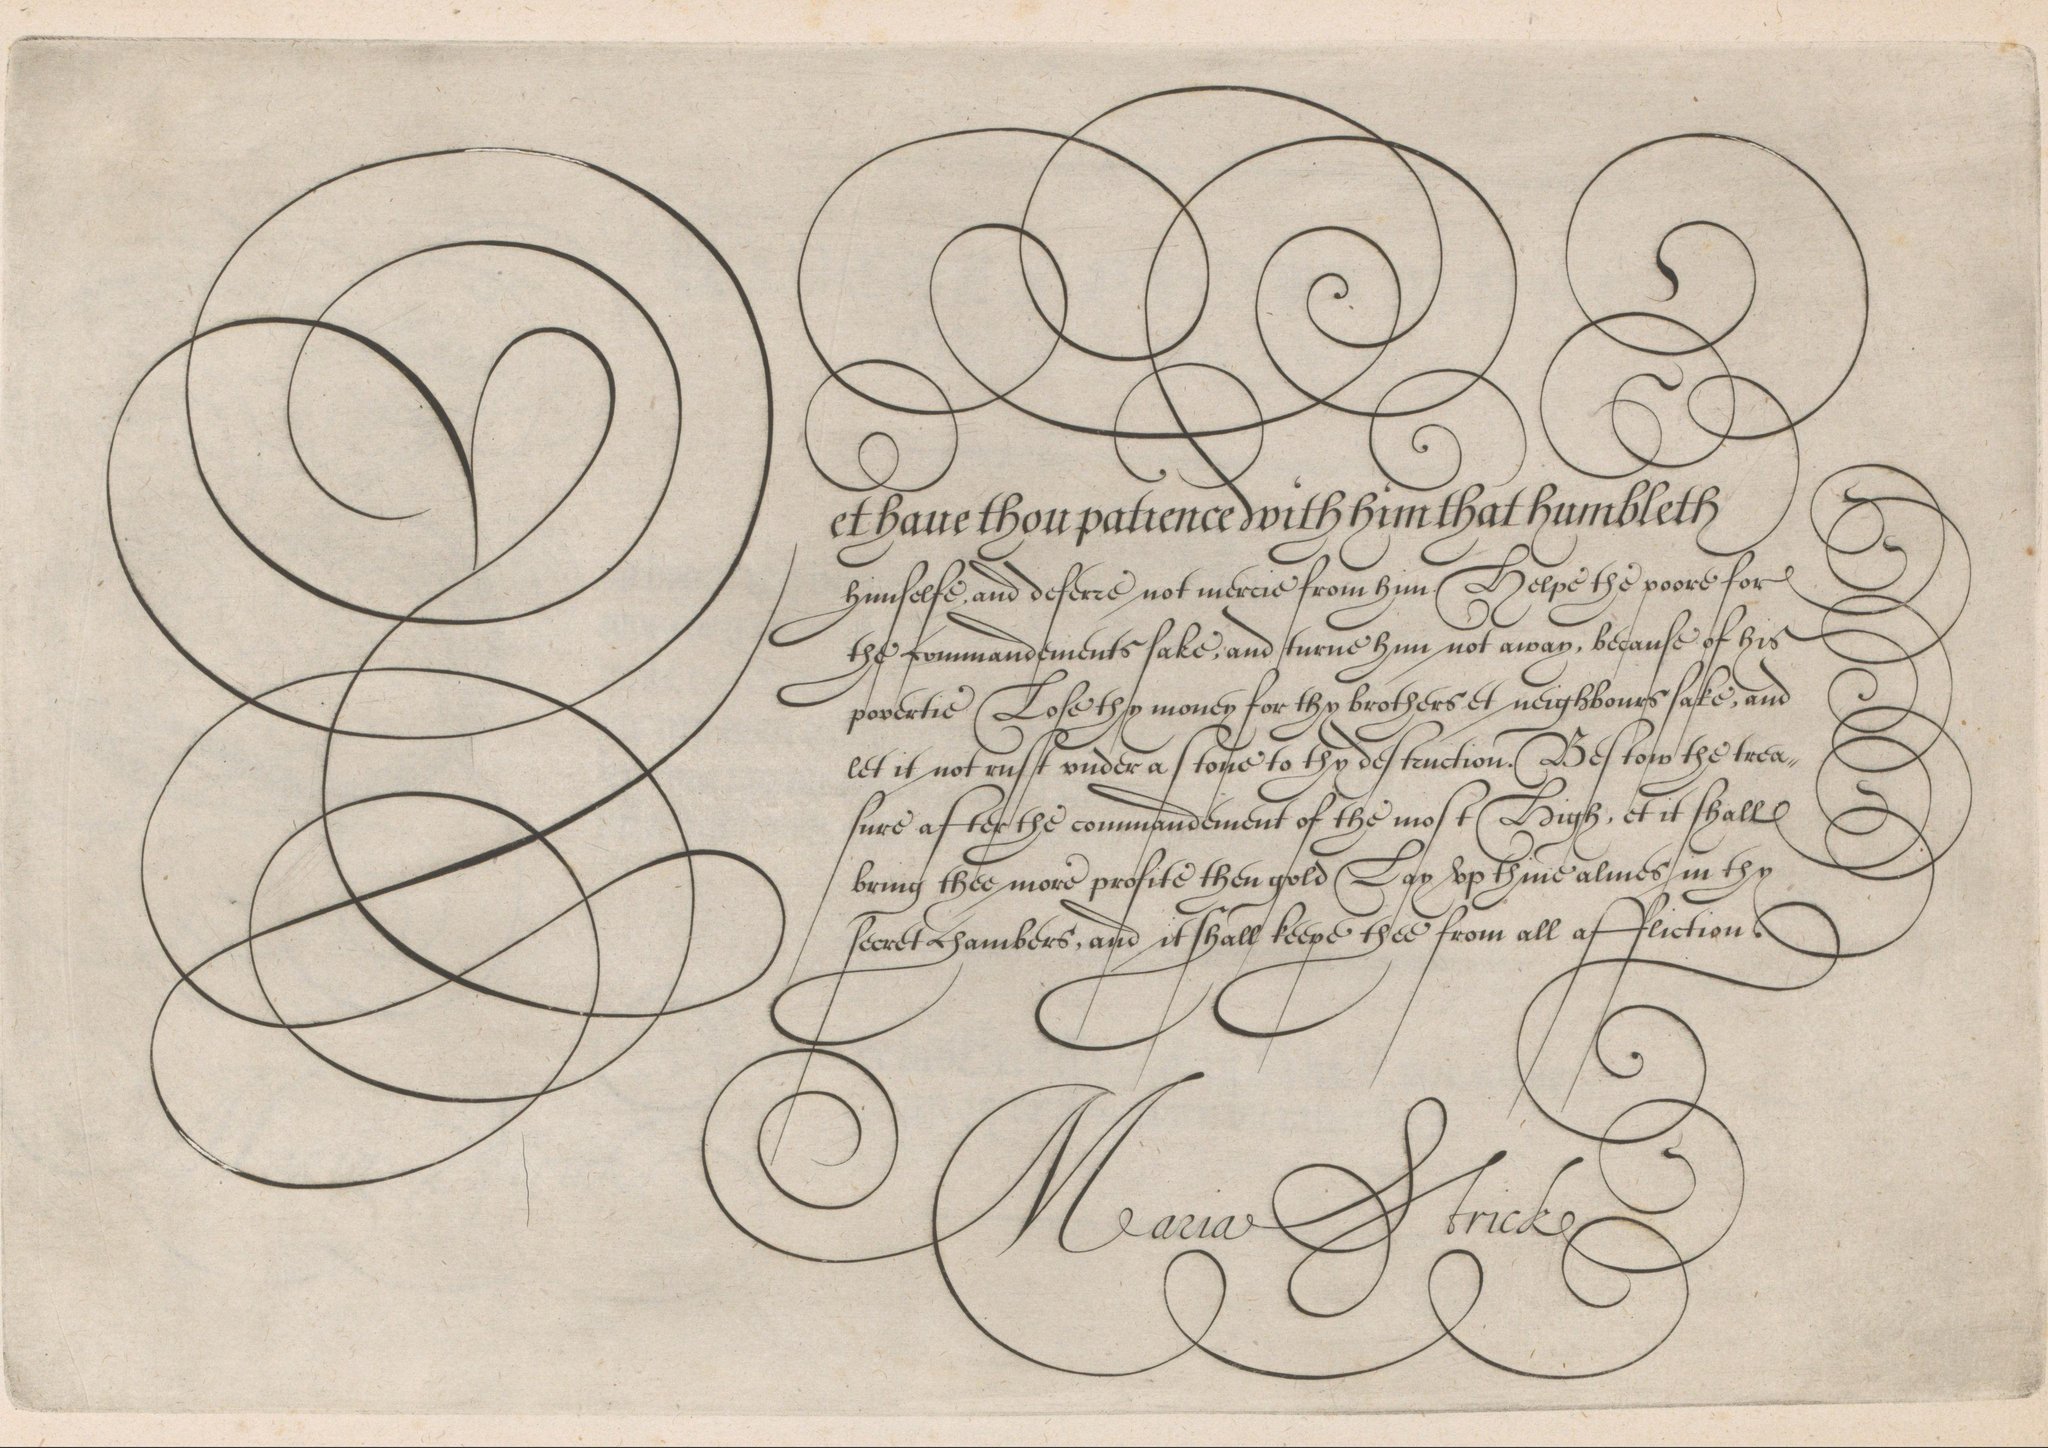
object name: ornament print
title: Schat oft voorbeelt ende verthooninge van verscheyden geschriften (...)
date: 1618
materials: paper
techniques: engraving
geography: rotterdam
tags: calligraphy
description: Schrijfvoorbeeld in het Engels met acht regels tekst: Yet have thou patience with him (...). Omlijst door kalligrafisch krulwerk. De prent maakt deel uit van een album.